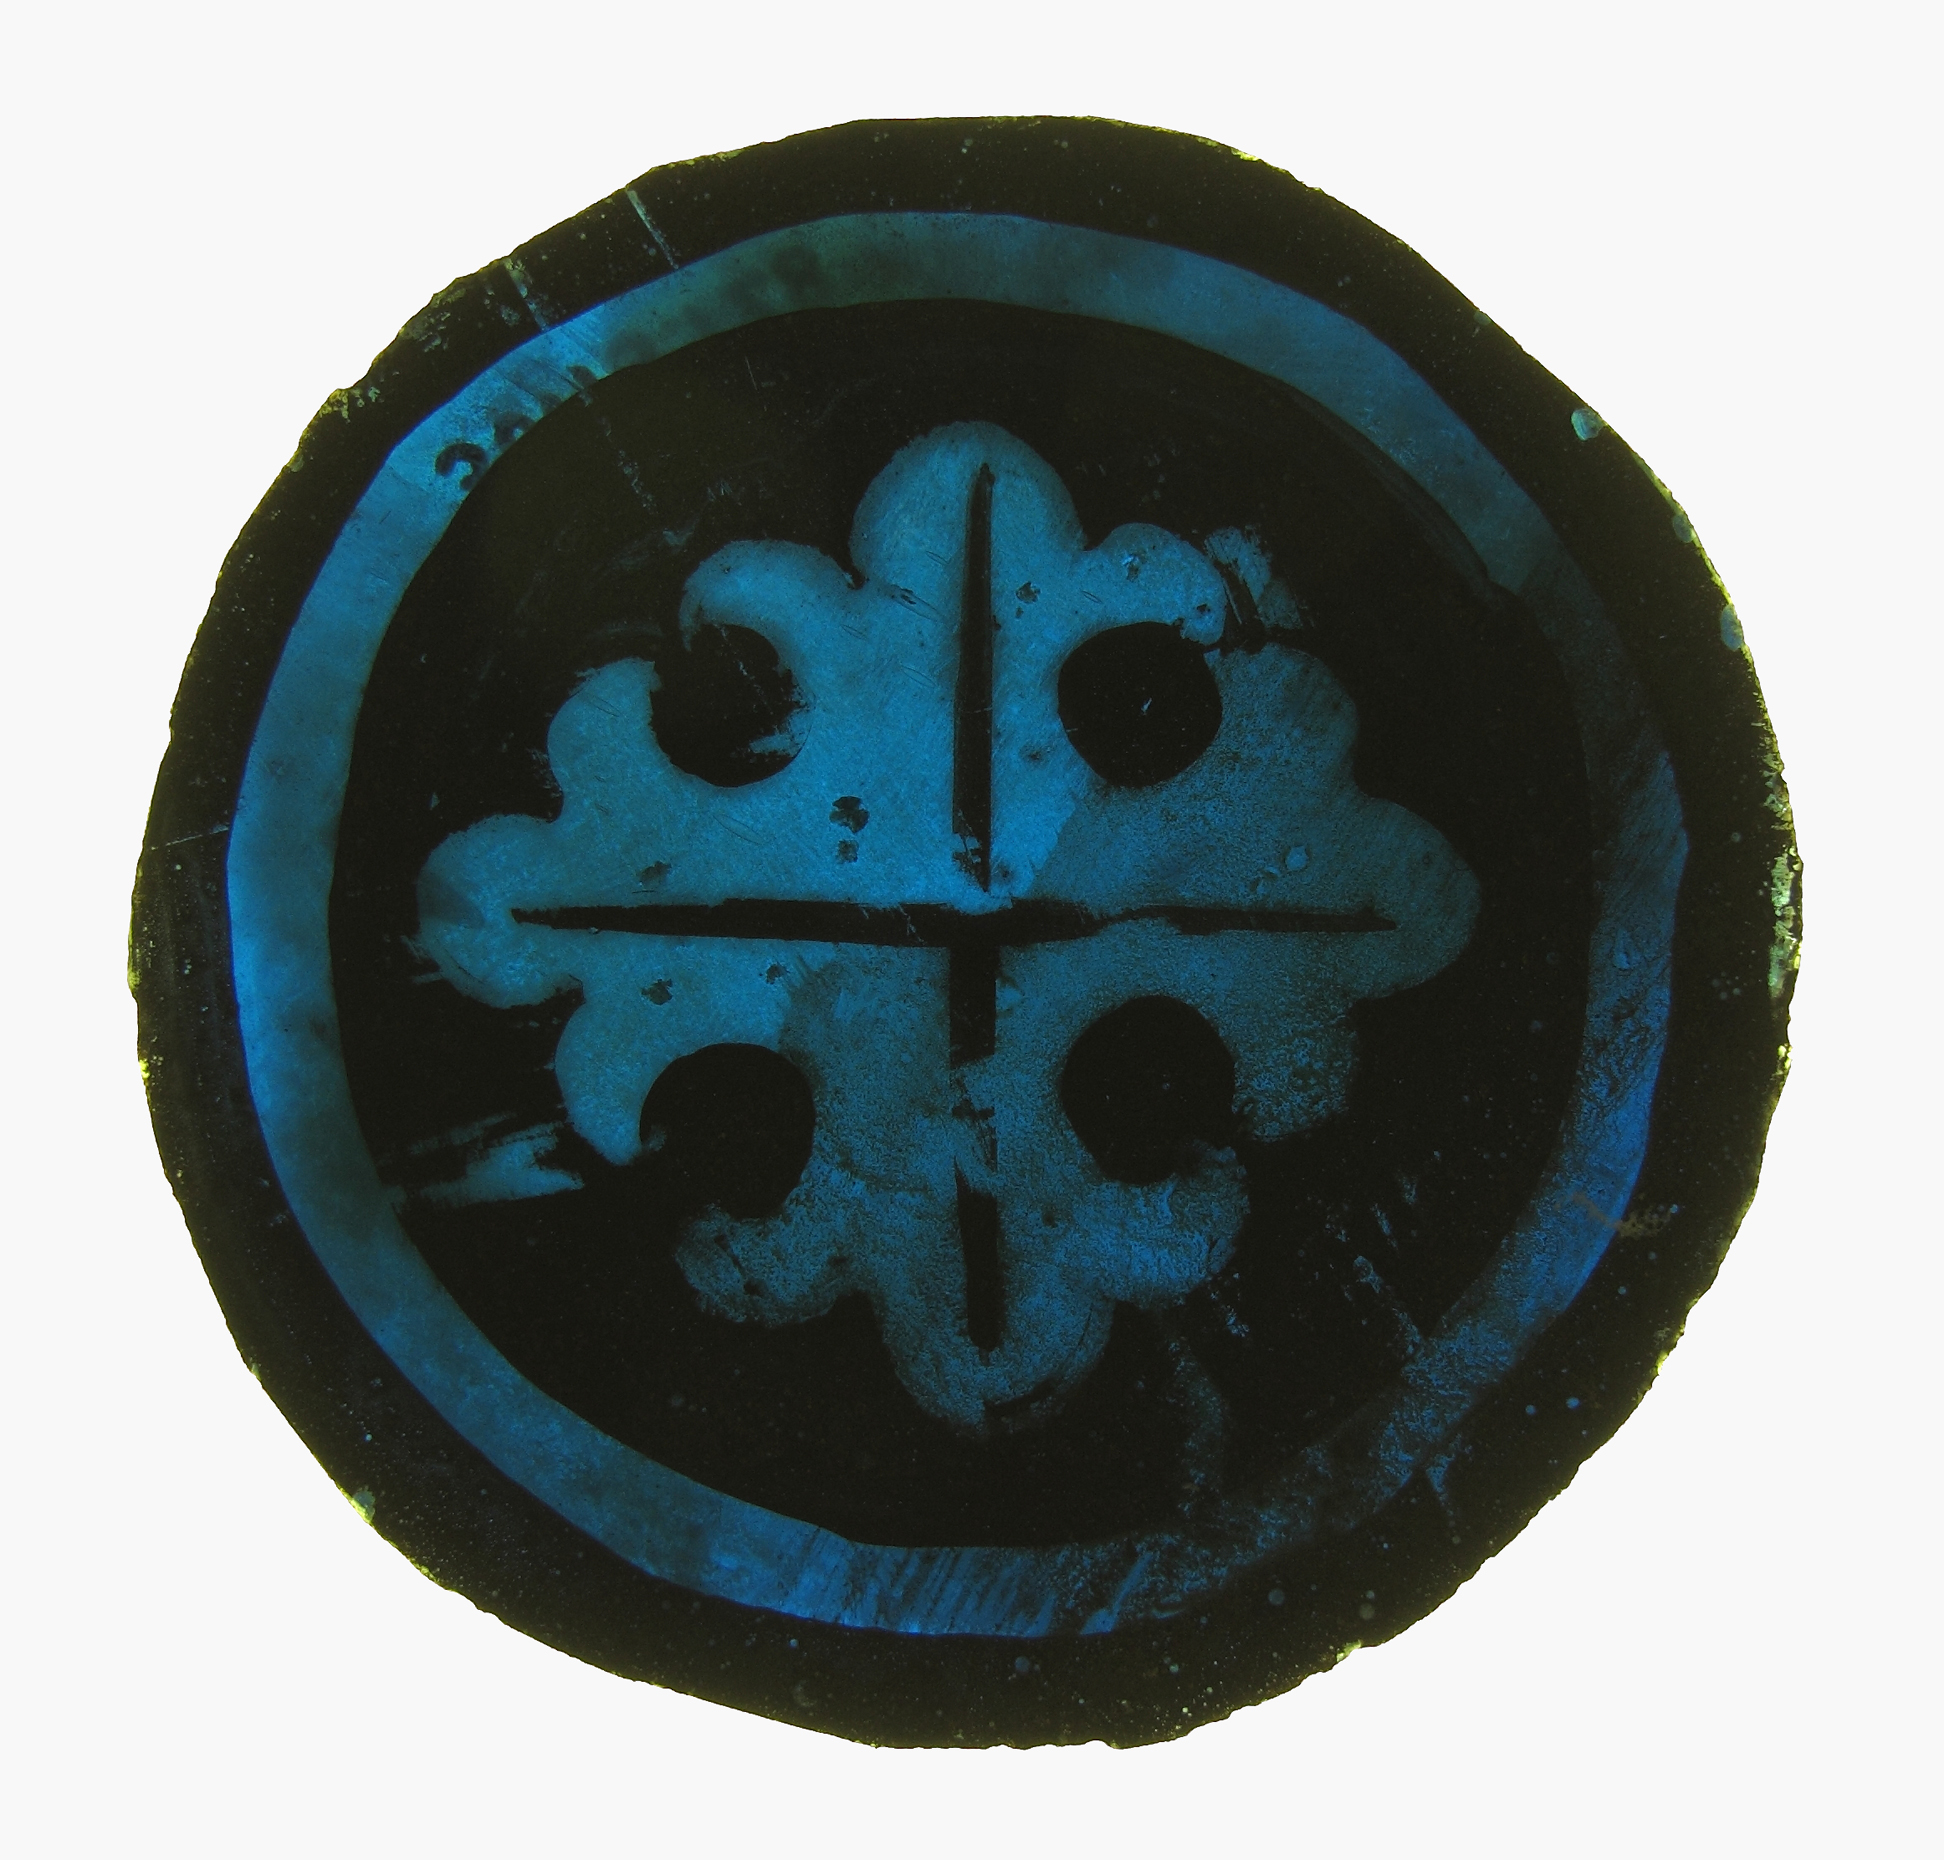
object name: fragment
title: Glass Fragment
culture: european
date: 1201-1400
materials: glass, metal